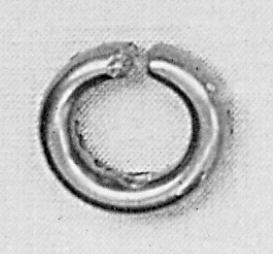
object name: earring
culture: japanese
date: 601-700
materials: gold